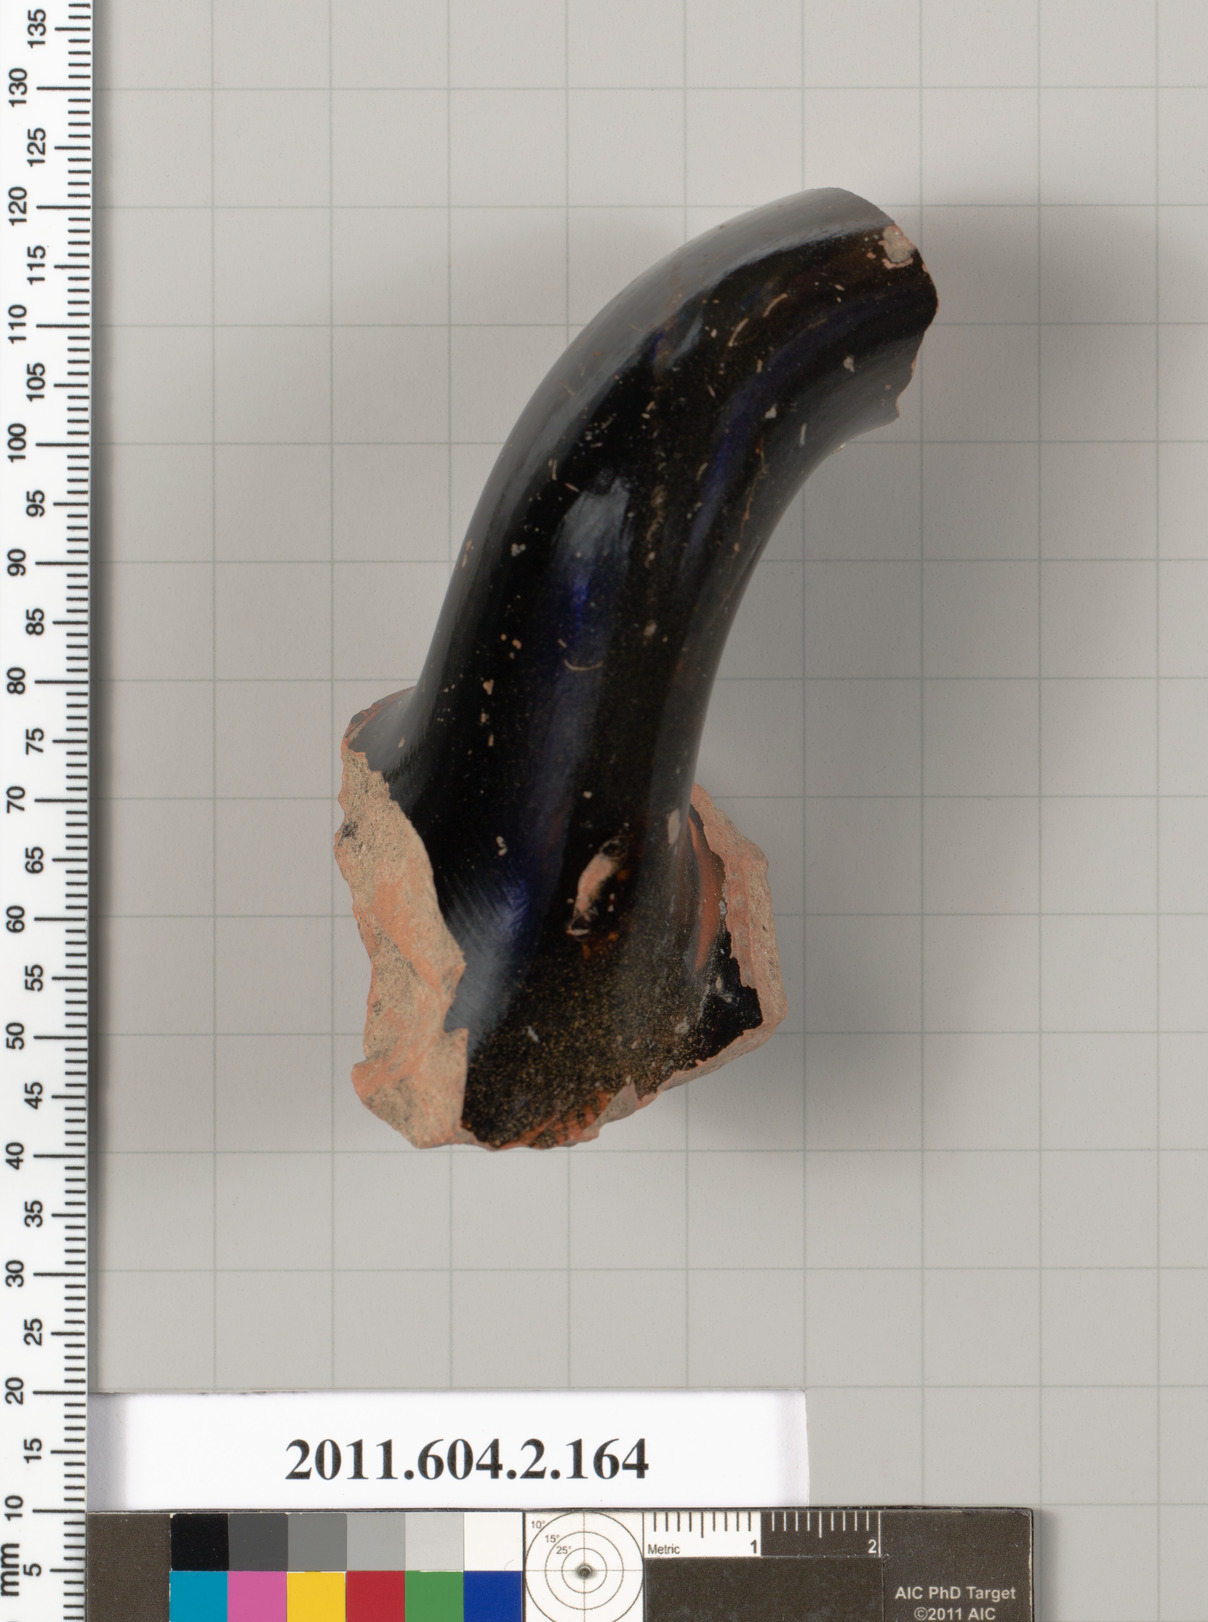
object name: stamnos fragment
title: Terracotta fragment of a stamnos (jar)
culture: greek, attic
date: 475-451 BCE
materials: terracotta